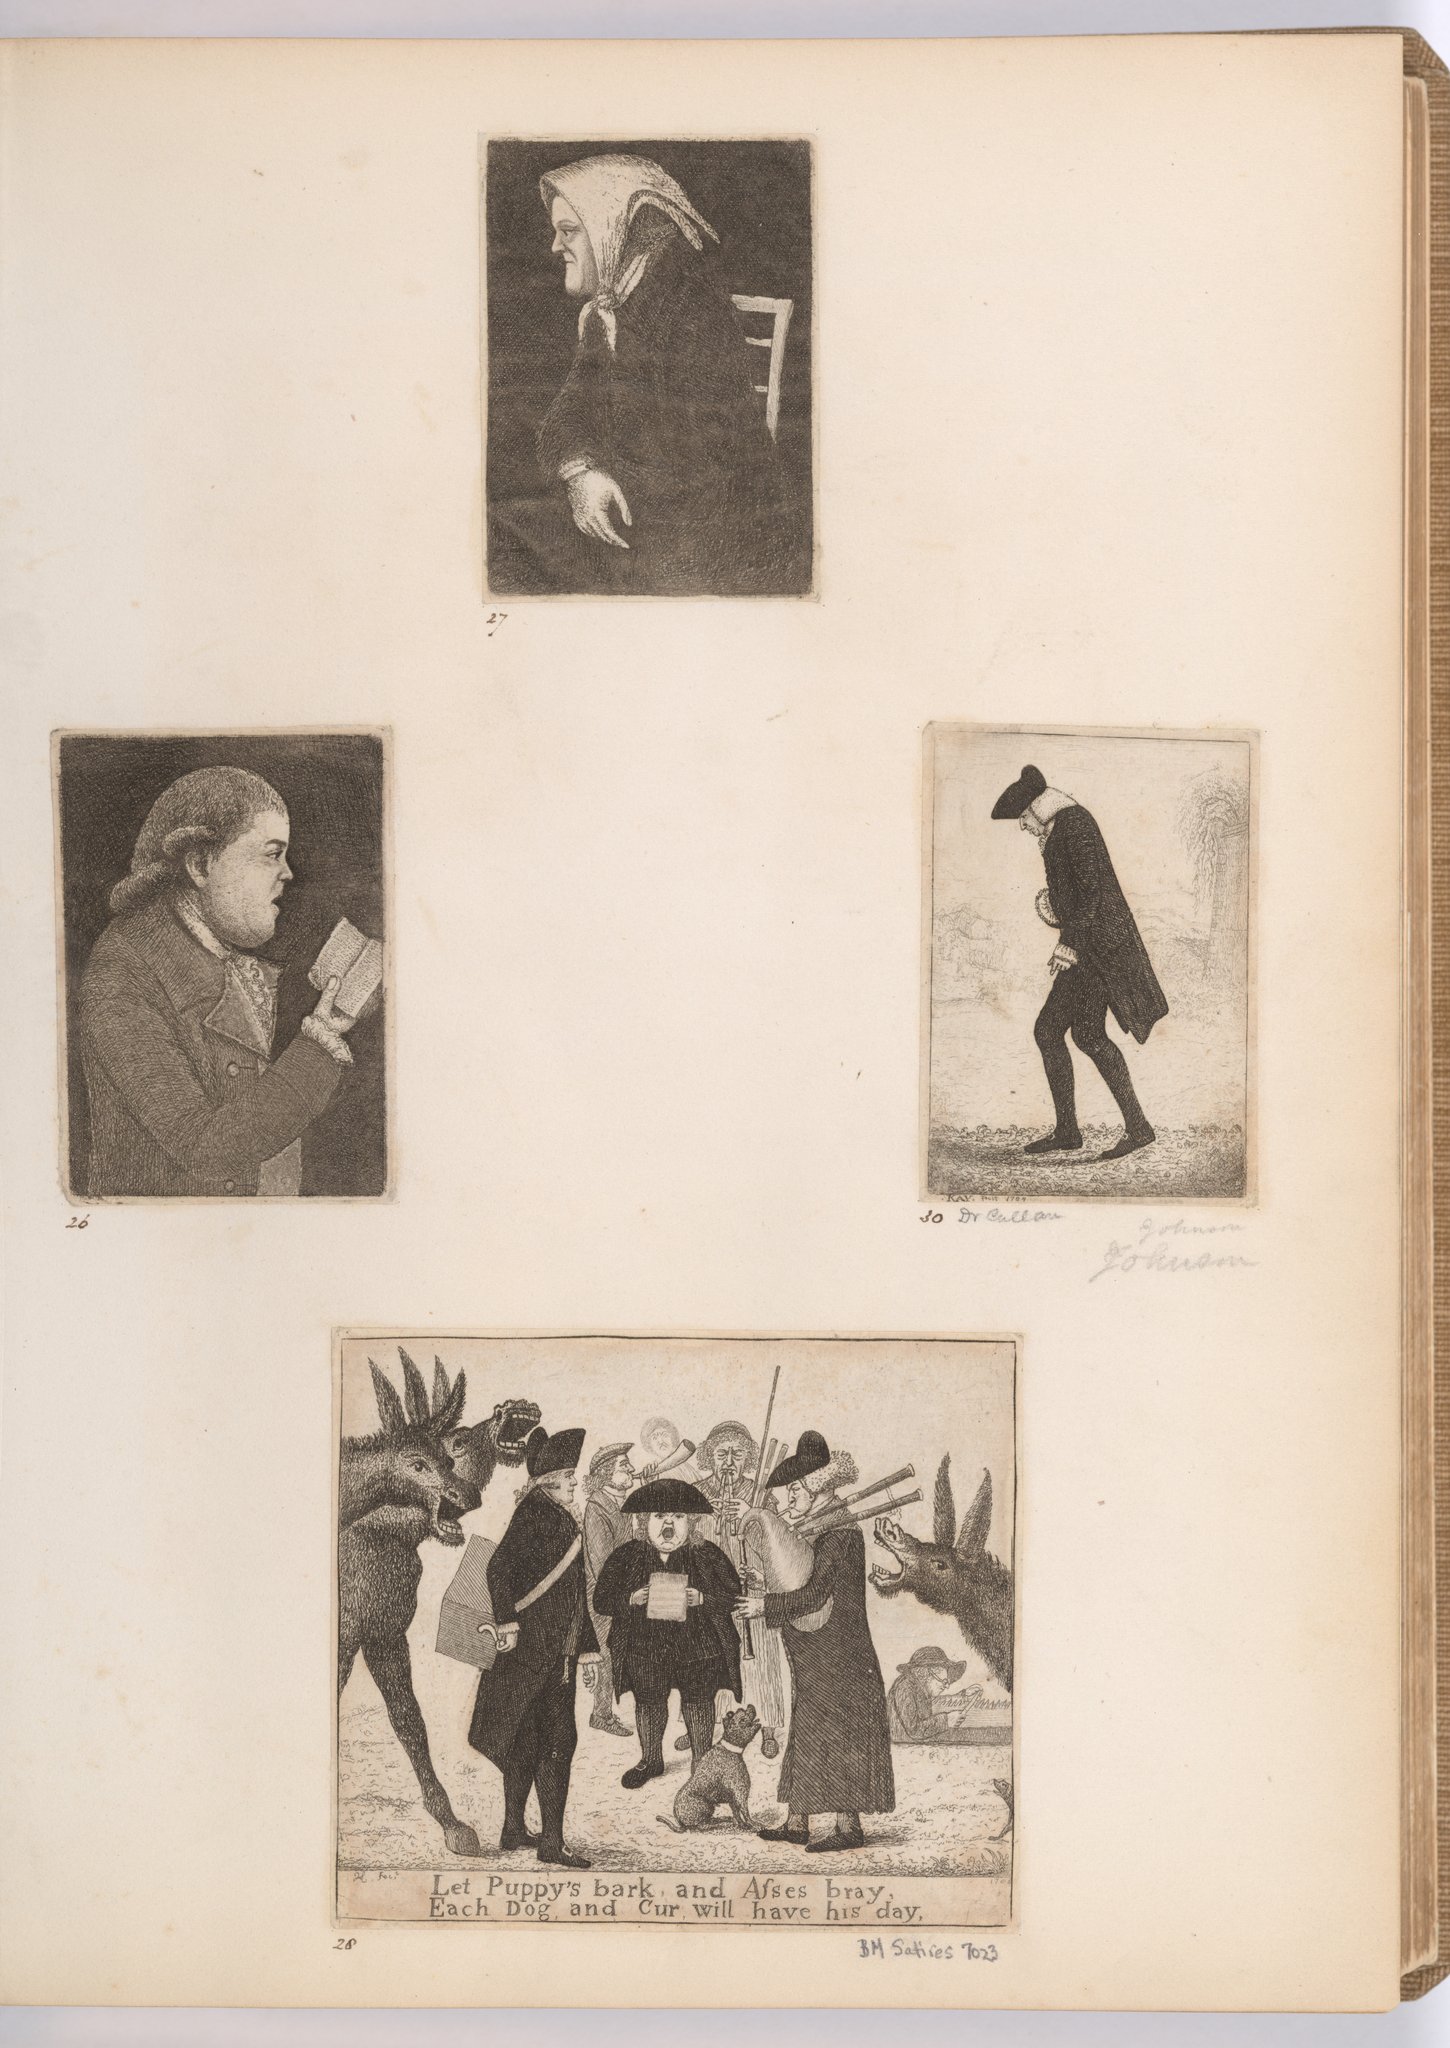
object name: print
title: Dr. William Cullen, Late Professor of Medicine in the University of Edinburgh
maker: john kay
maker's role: artist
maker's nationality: british, scottish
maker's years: 1742-1826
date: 1784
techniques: etching